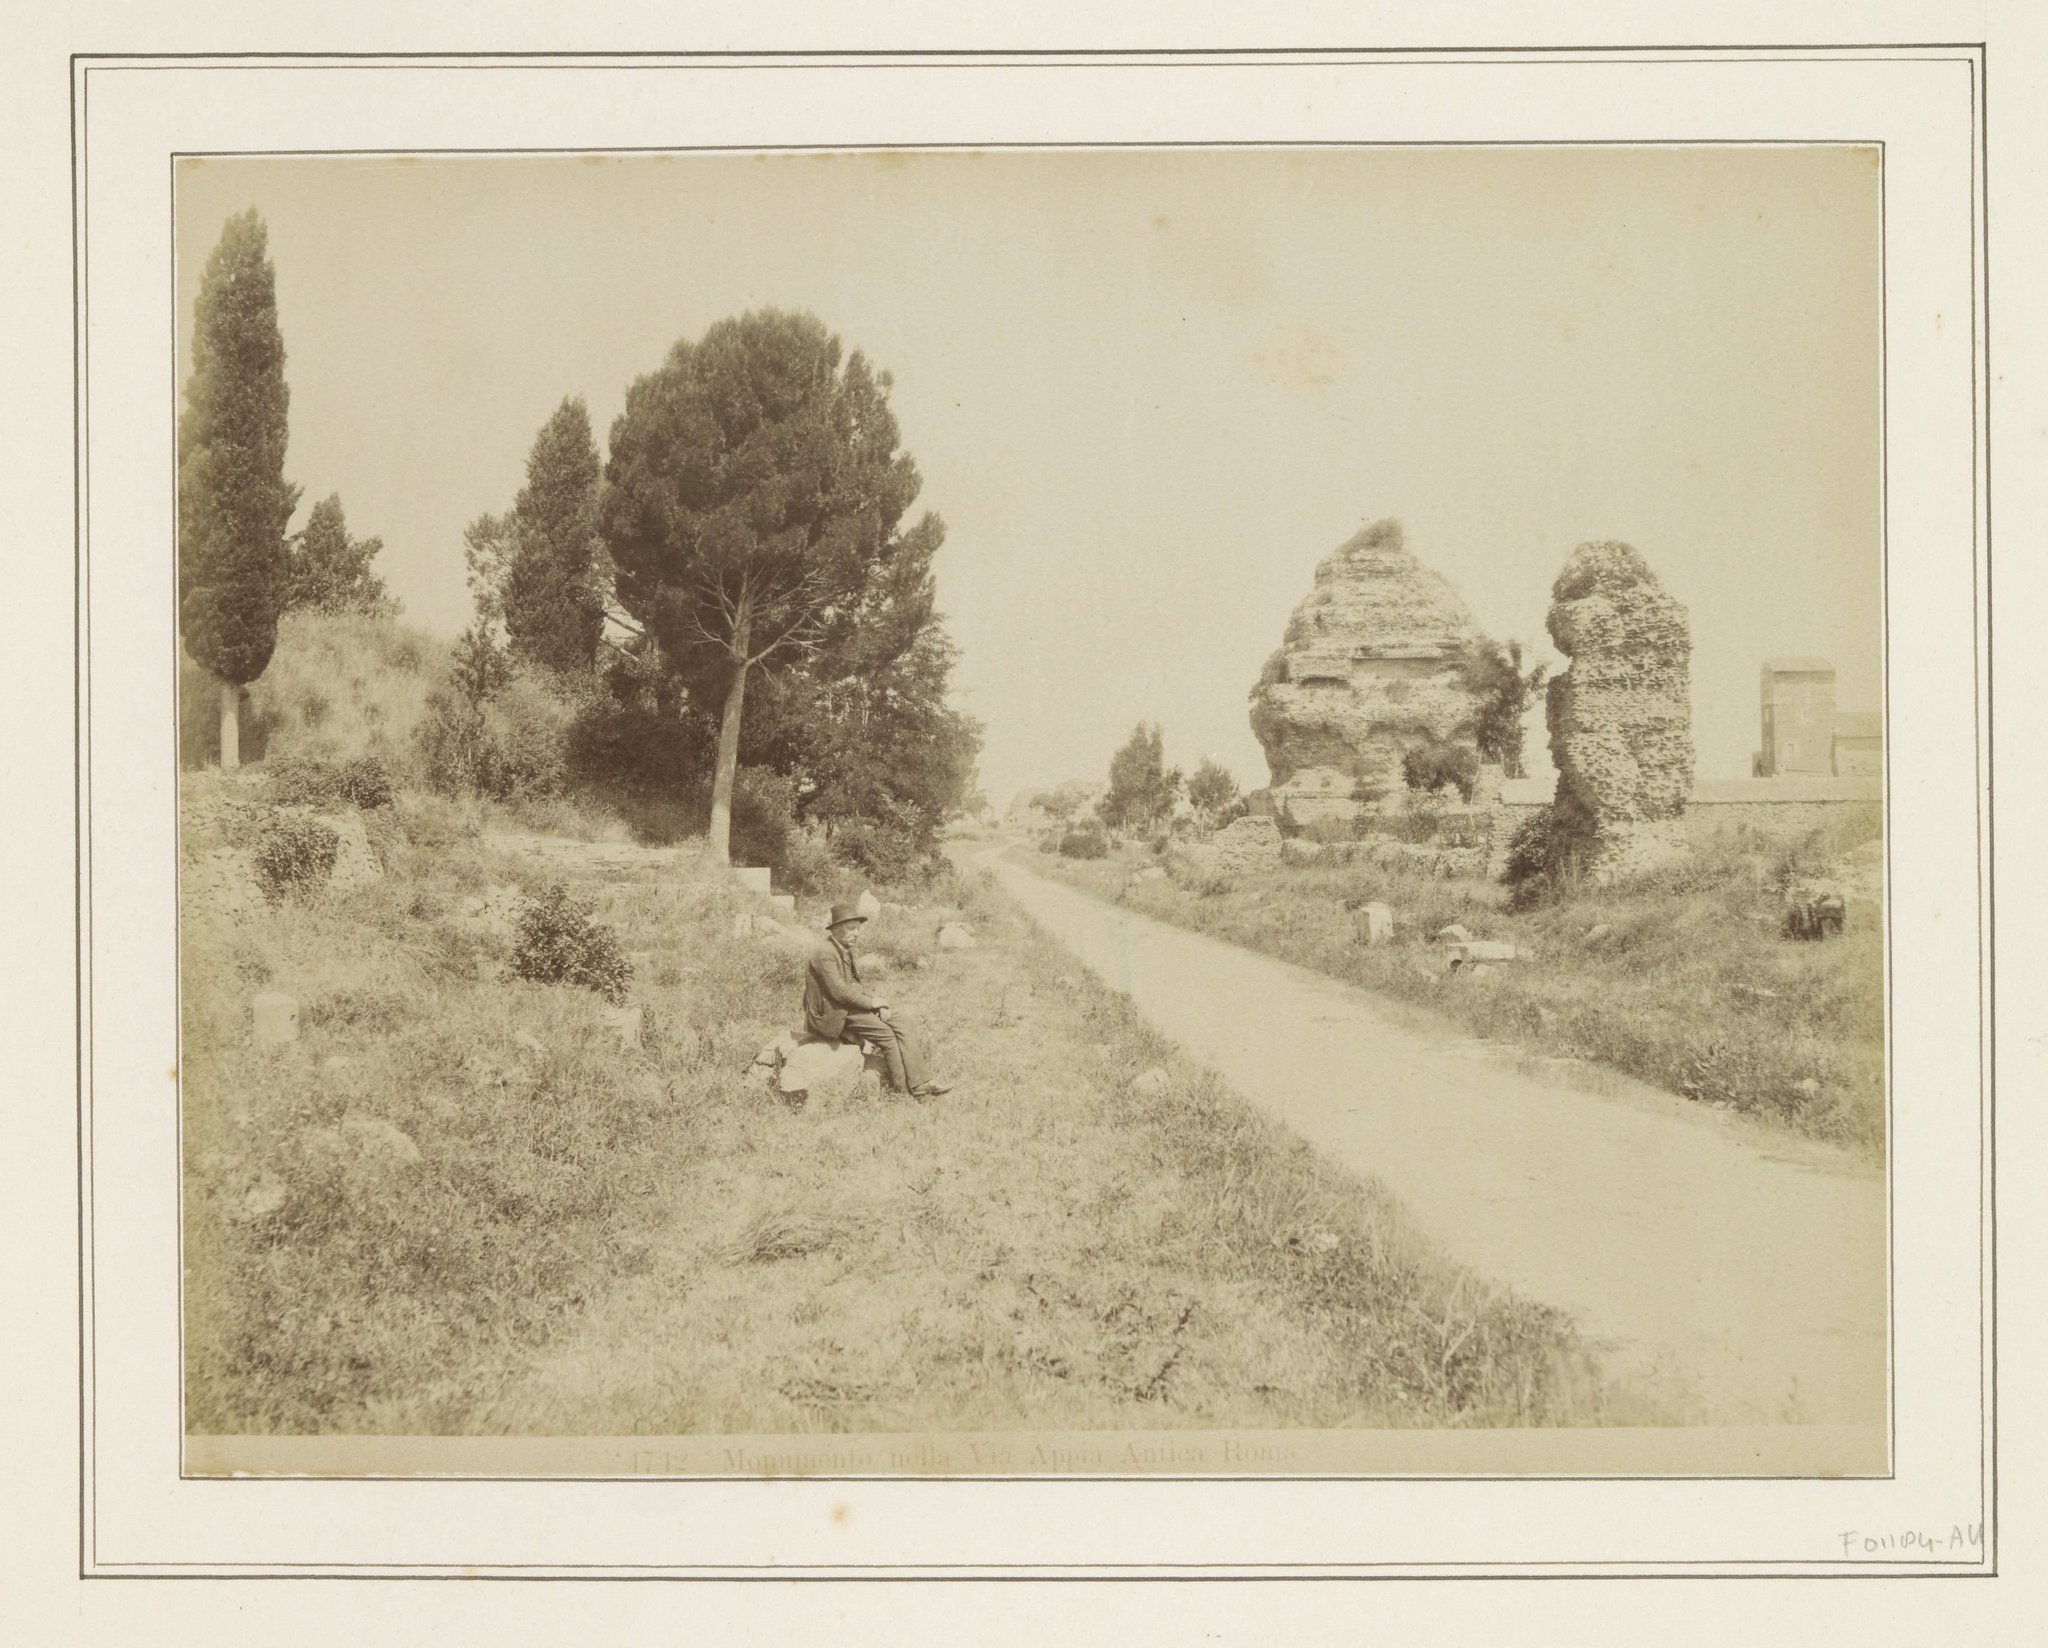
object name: photograph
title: Monumento nello Via Appia Antica Roma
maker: Anonymous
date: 1865-1890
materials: paper, photographic support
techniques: albumen print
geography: via appia antica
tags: (traveller) resting in the open air, landscape with ruins, road, path, rome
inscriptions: negative number: ‘1712’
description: Onderdeel van Reisalbum met foto's van bezienswaardigheden in Italië (deel I).